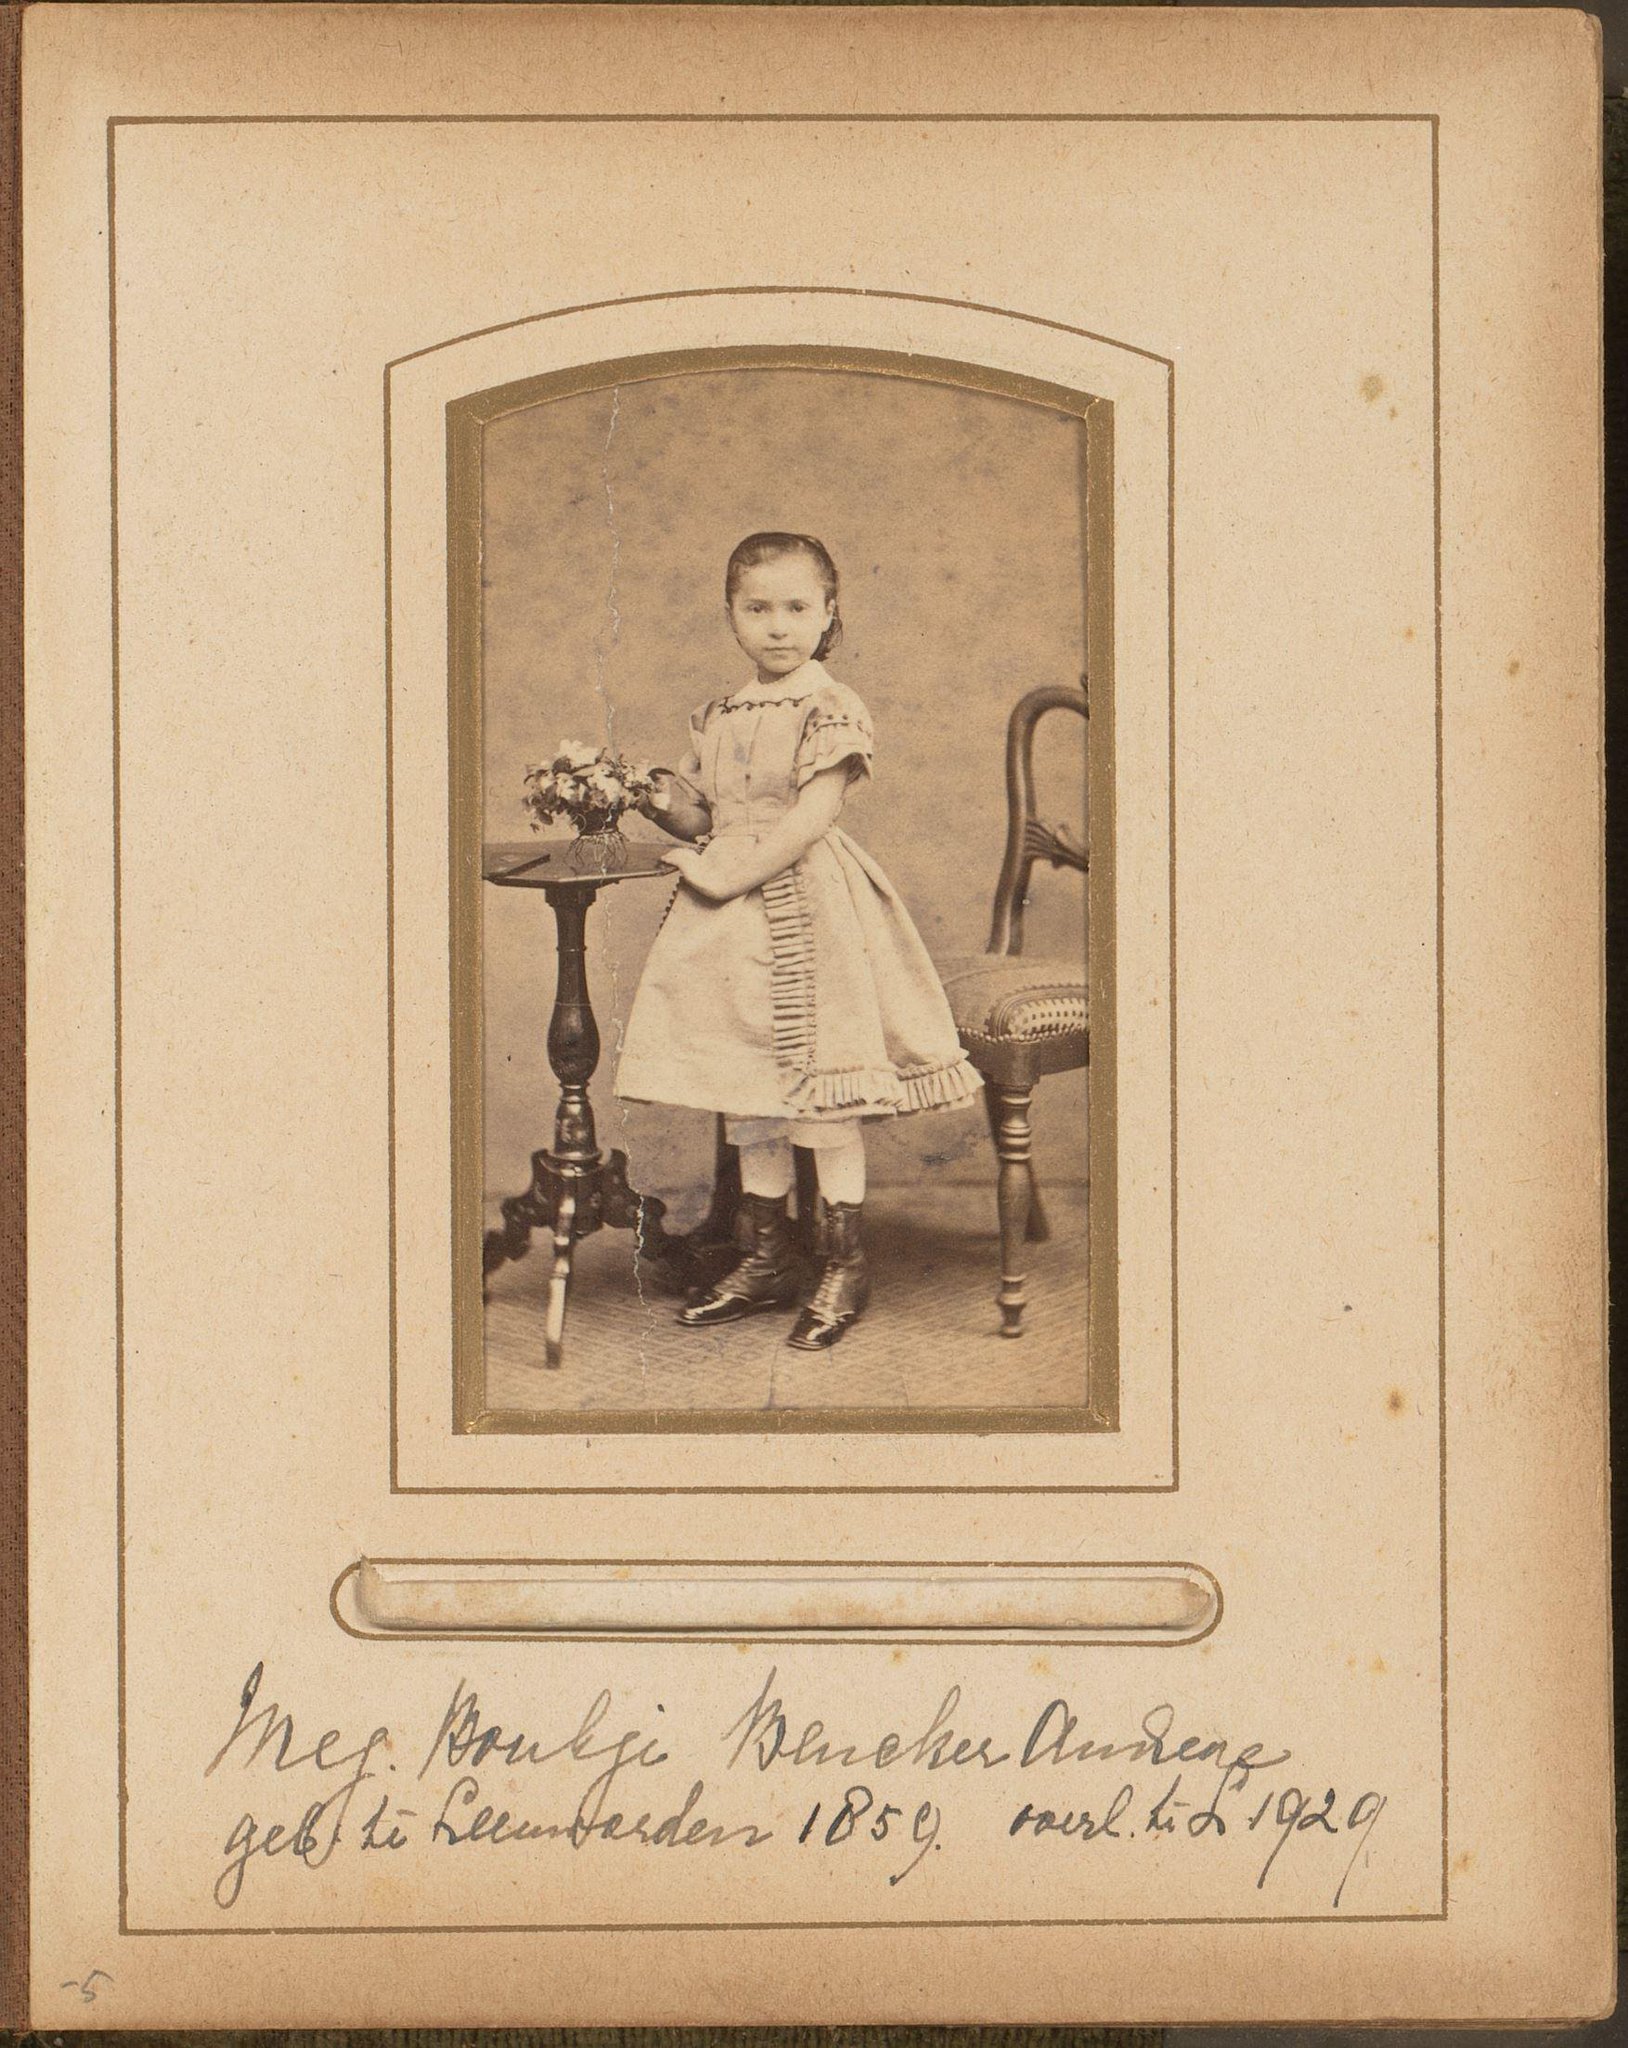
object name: album leaf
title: Portret van Boukje Beucker Andreae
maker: Anonymous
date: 1860-1875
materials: cardboard, paper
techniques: albumen print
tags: historical persons, girl (child between toddler and youth)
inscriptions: inscription: ‘Mej. Boukje Beucker Andreae/ geb. te Leeuwarden 1859./ overl. te L 1929’